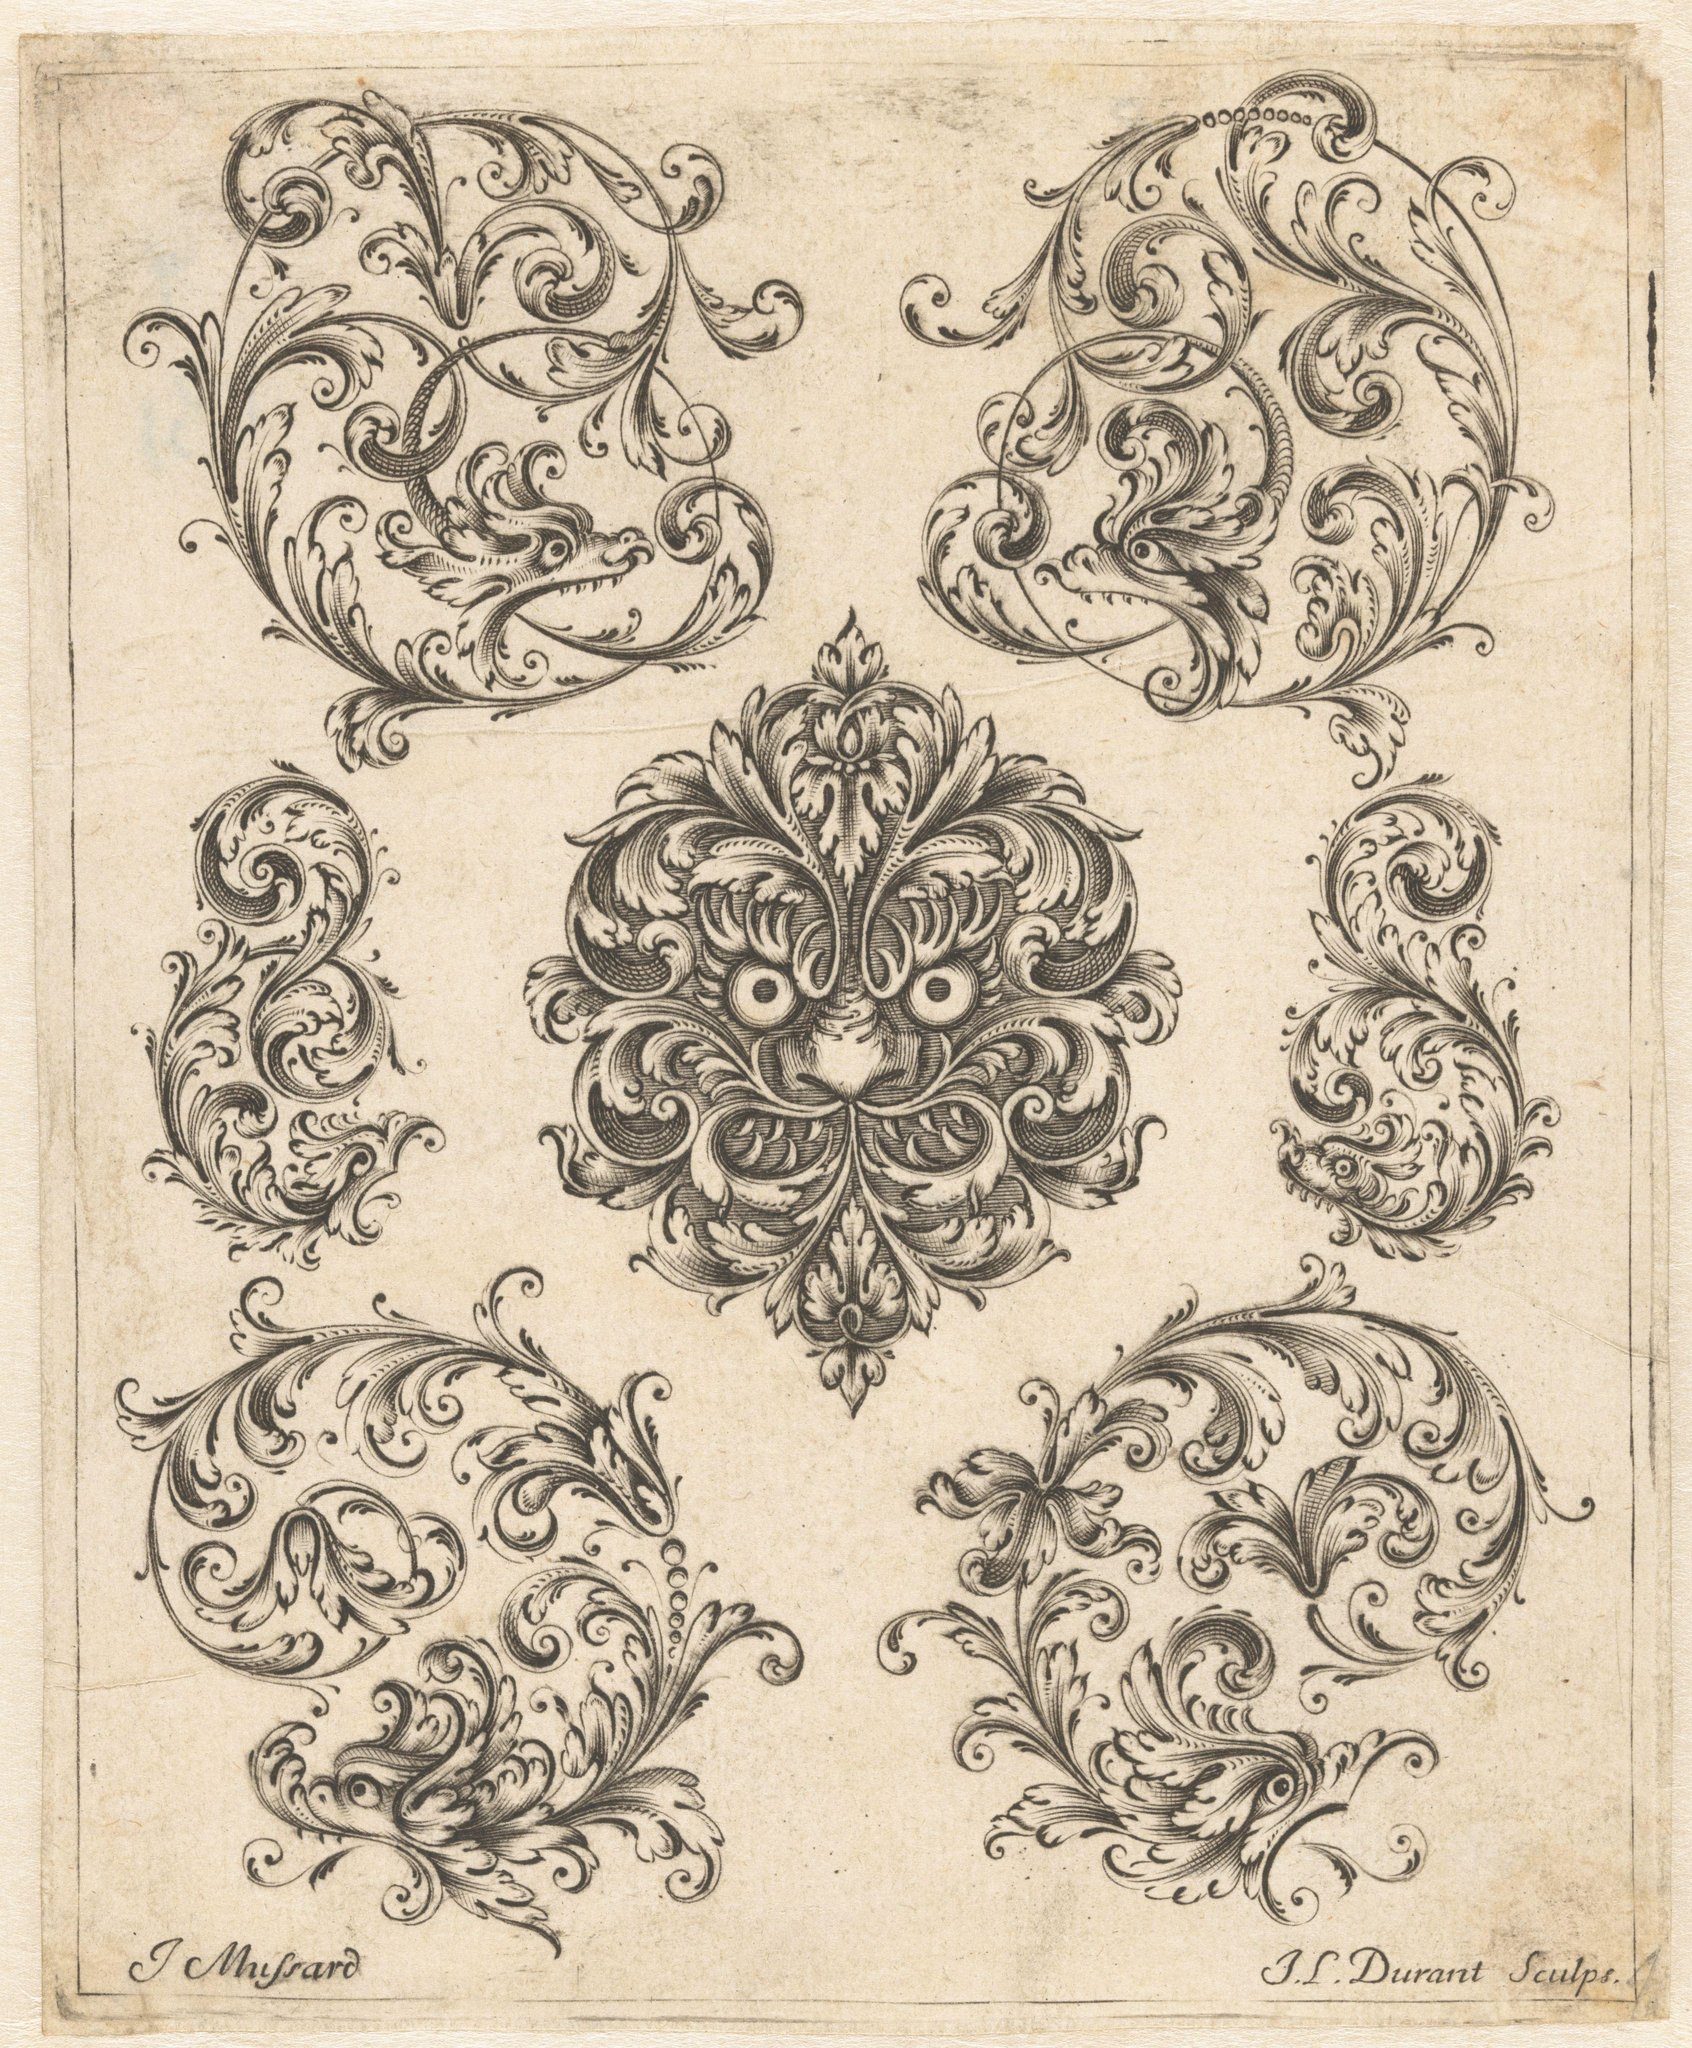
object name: ornament print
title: Ontwerpen voor edelsmeden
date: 1673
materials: paper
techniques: engraving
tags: ornaments ~ art, foliage ~ ornament, mask, mascaron ~ ornament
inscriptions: collector's mark: Lugt 2228, signature: ‘J. L. Durant Sculps.’, collector's mark: Lugt 2760, collector's mark: Lugt 190, signature: ‘J Mussard’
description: Blad uit een serie van zes bestaande uit zeven ornamentele gebladerde ontwerpen voor edelsmeden, waarvan de middelste bestaat uit een masker.